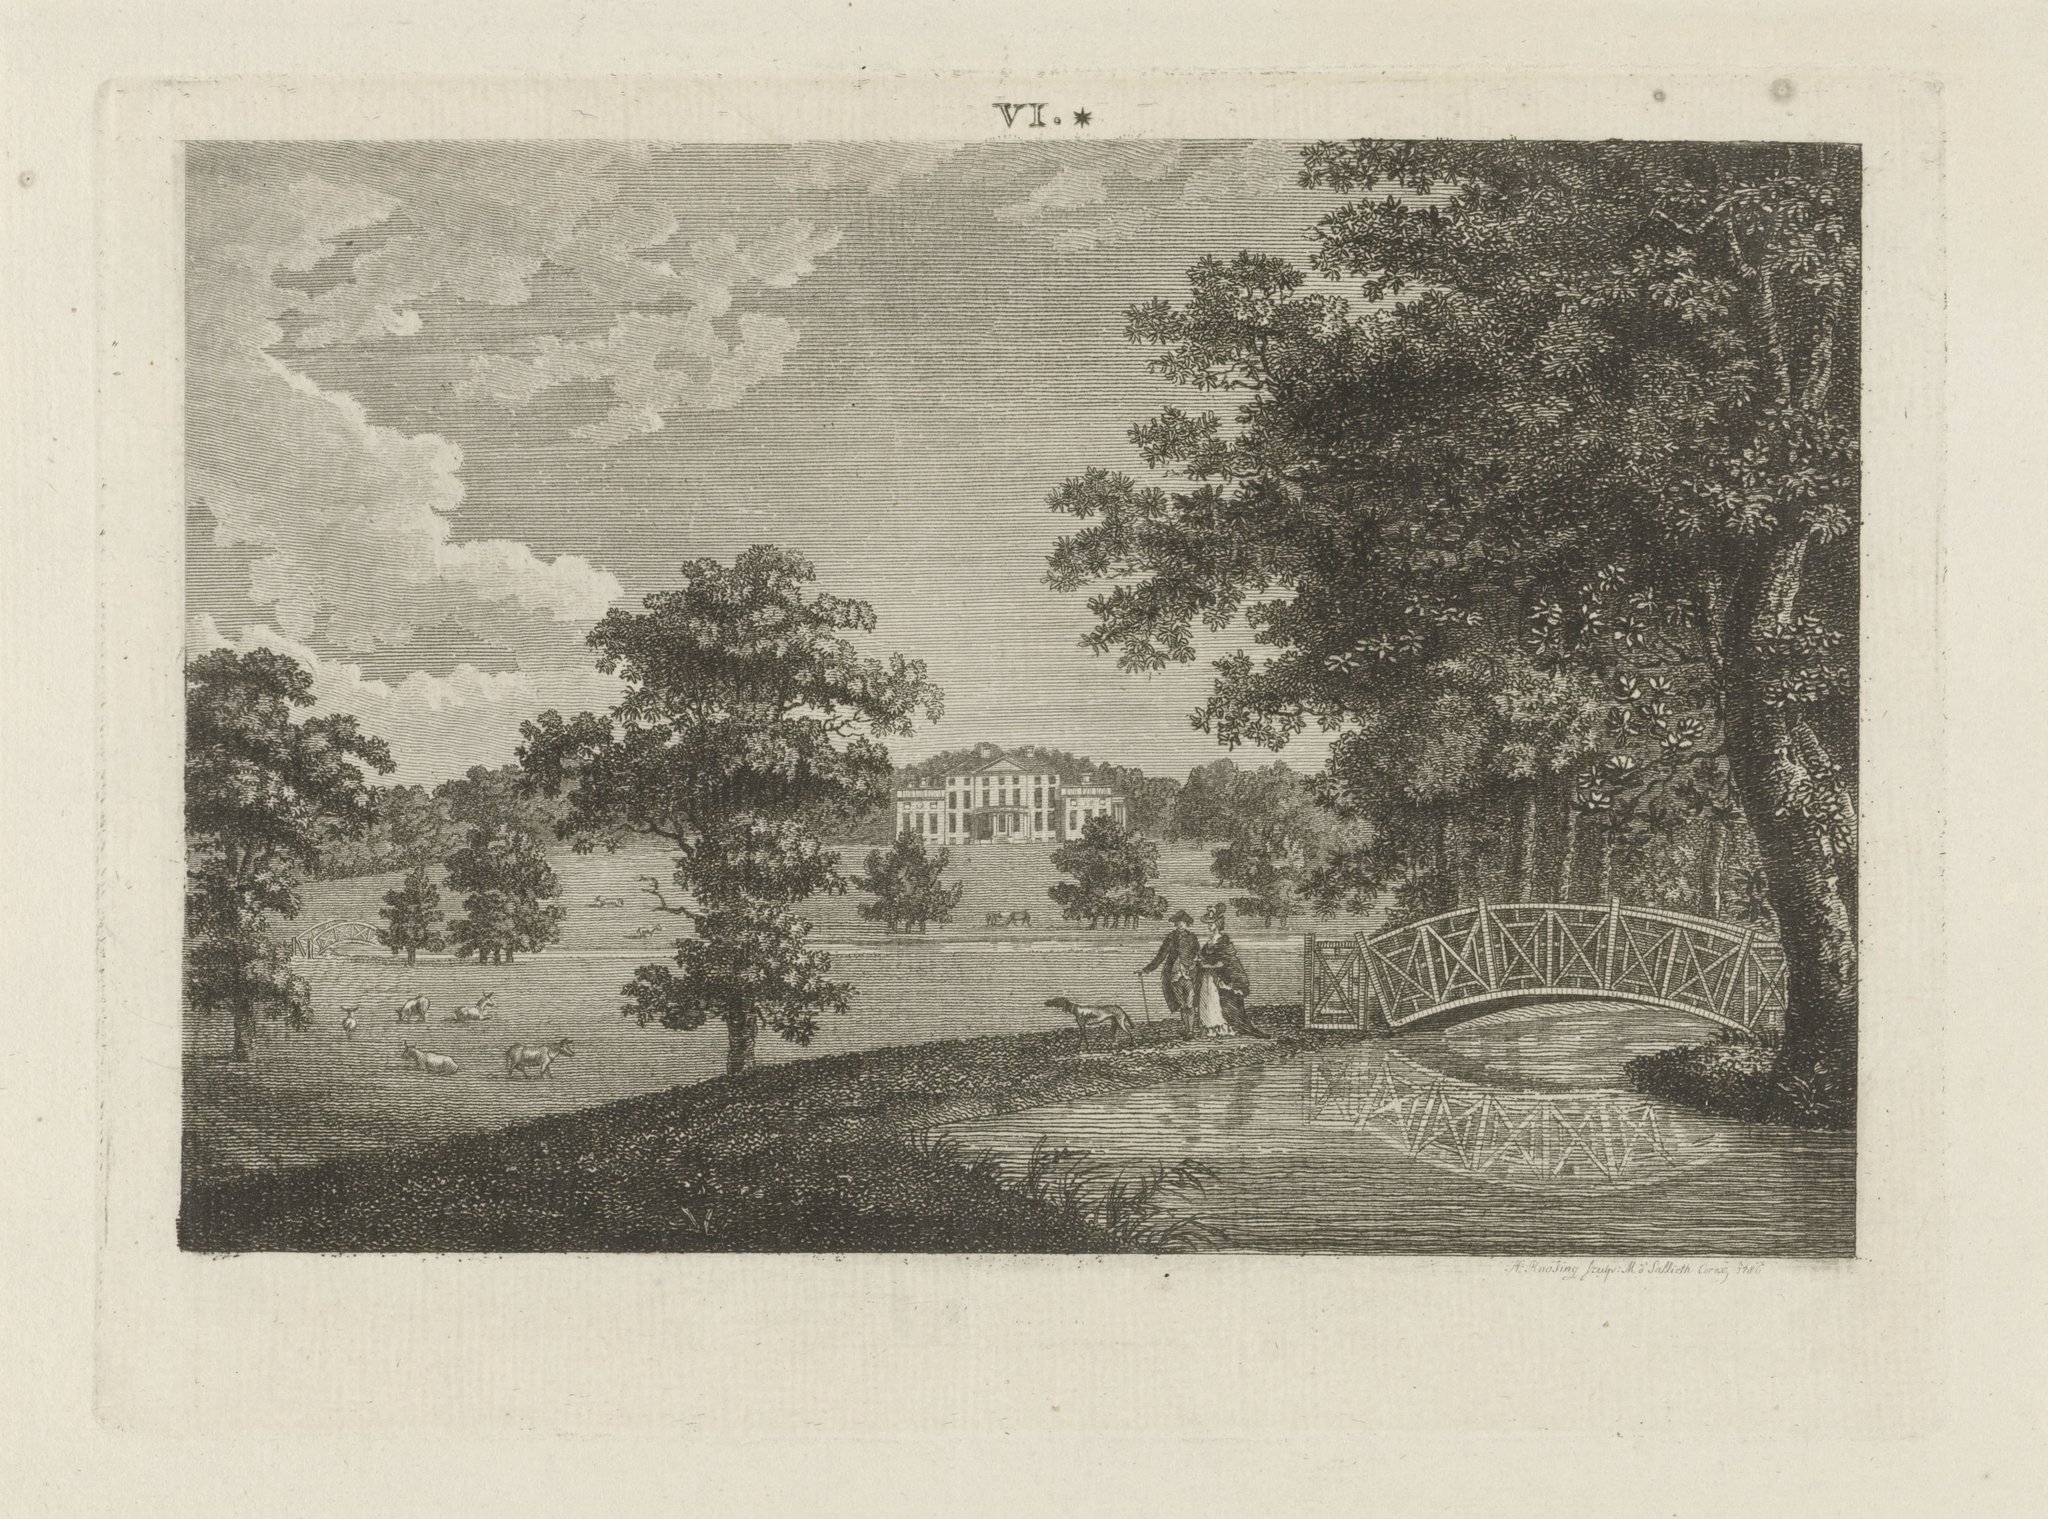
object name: print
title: Gezicht op Arnos Grove in Middlesex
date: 1786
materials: paper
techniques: etching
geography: rotterdam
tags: brook, villa, dog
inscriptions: collector's mark: Lugt 2228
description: Gezicht op het landgoed Arnos Grove in het voormalige Middlesex, tegenwoordig London. Op de voorgrond een elegant gekleed paar met een hond bij een beek.